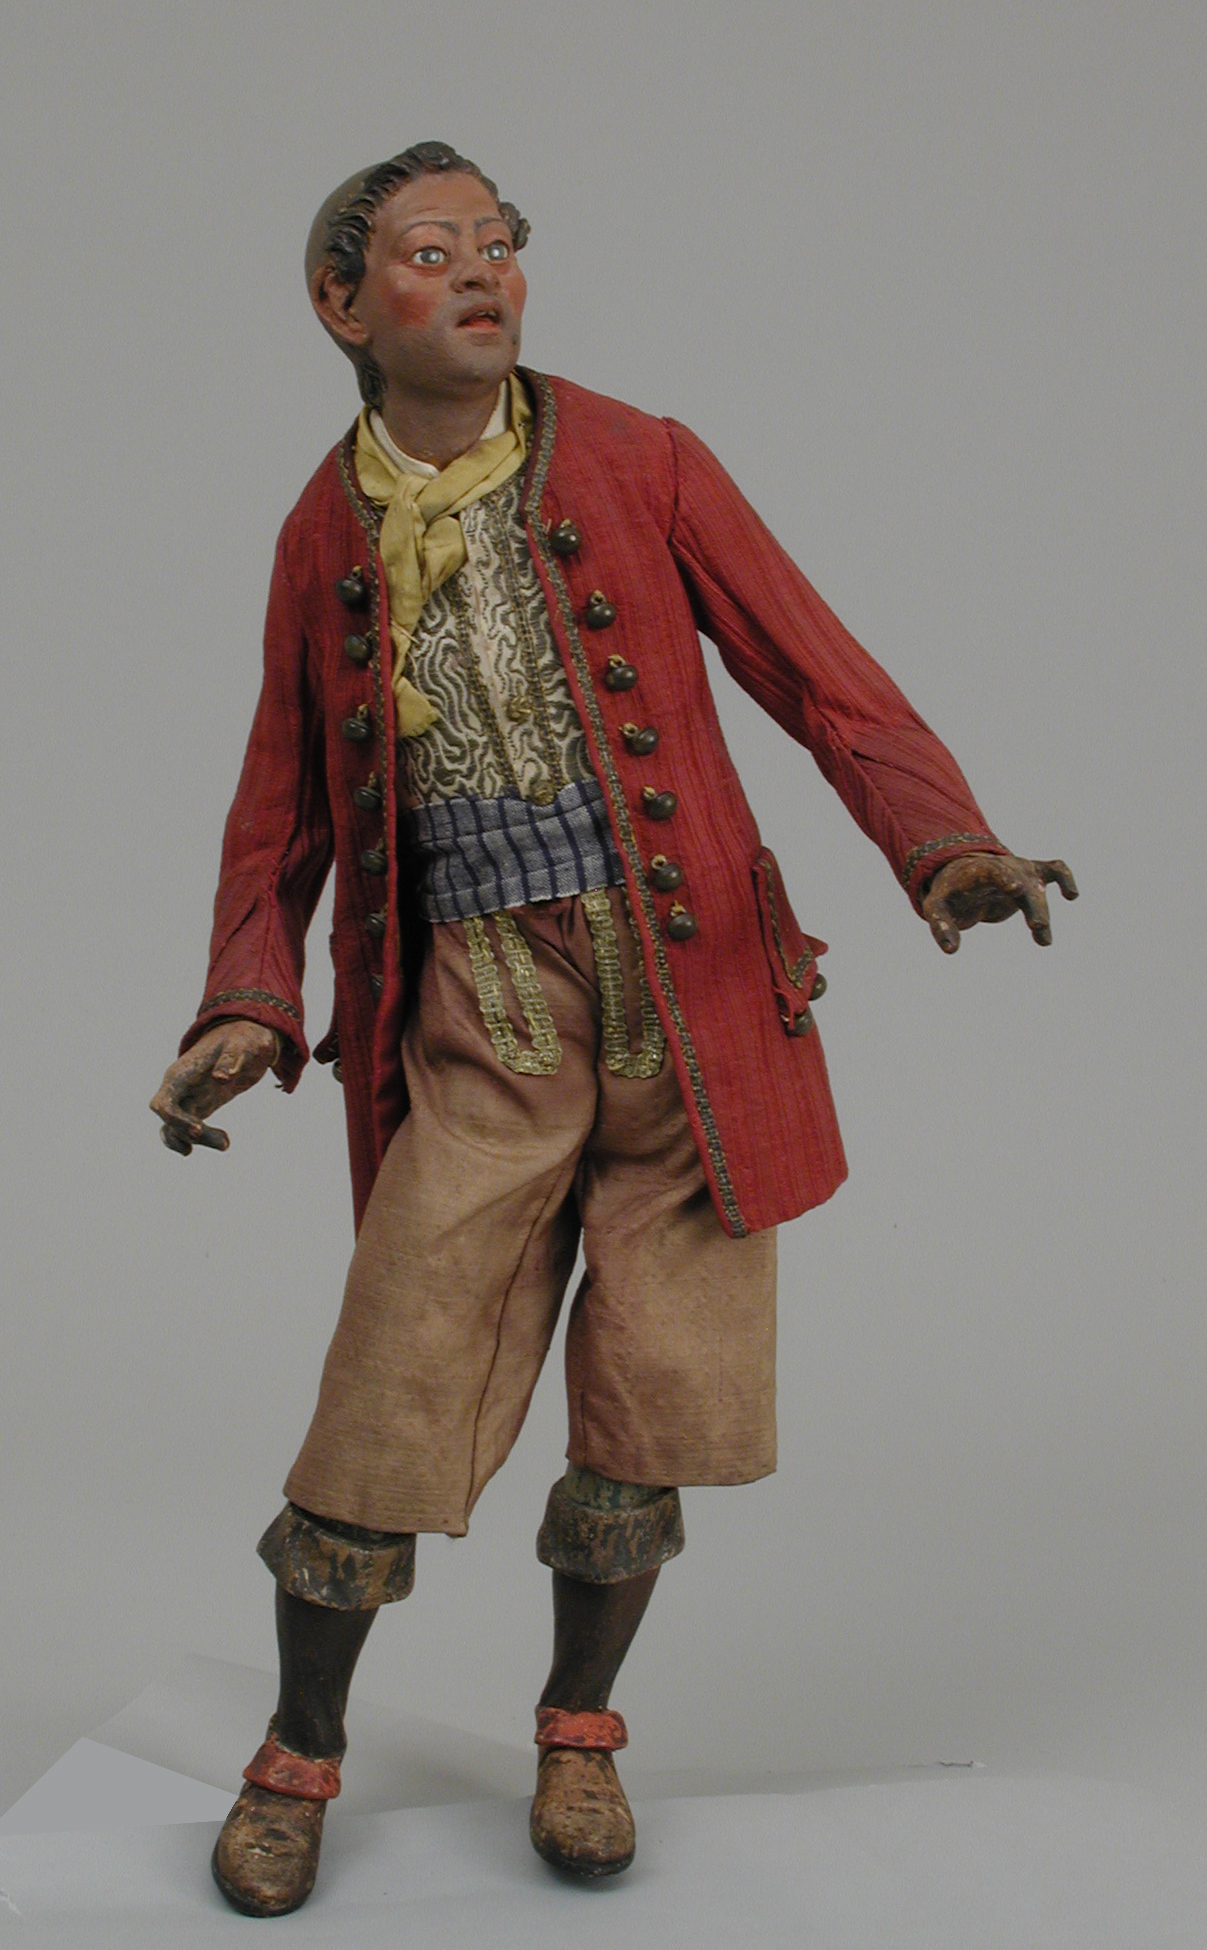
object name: crèche figure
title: Young man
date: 1767-1800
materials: terracotta, fiber, metal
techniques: polychrome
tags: men